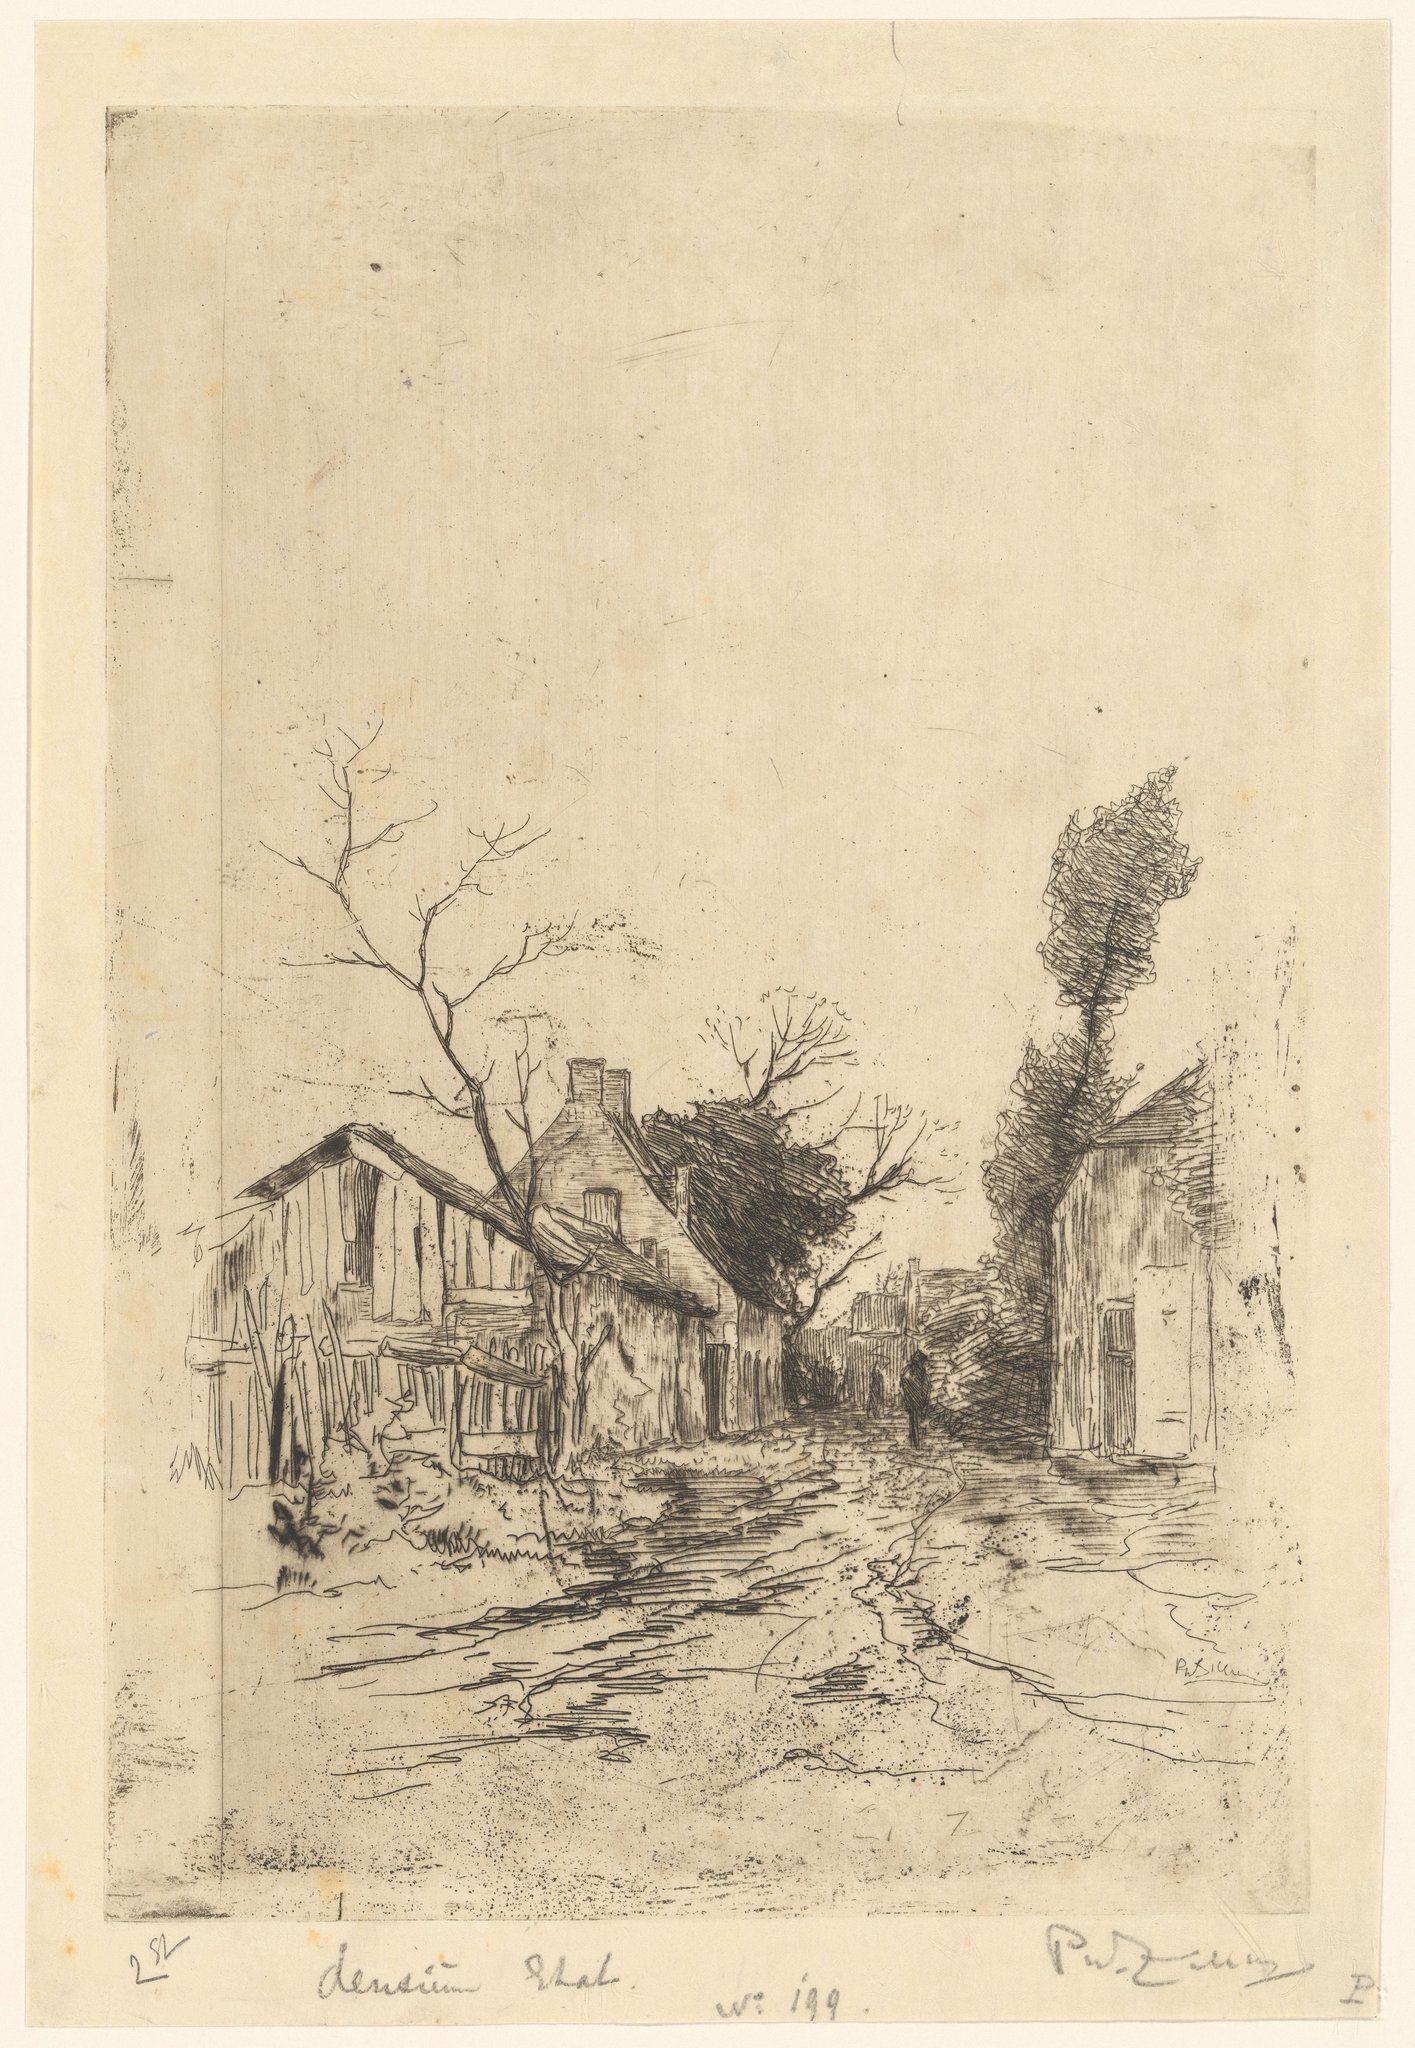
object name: print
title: Dorpsstraat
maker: philip zilcken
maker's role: draughtsman, painter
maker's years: 1857-1930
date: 1867-1890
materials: paper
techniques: drypoint, etching, intaglio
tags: village street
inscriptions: collector's mark: Lugt 2233